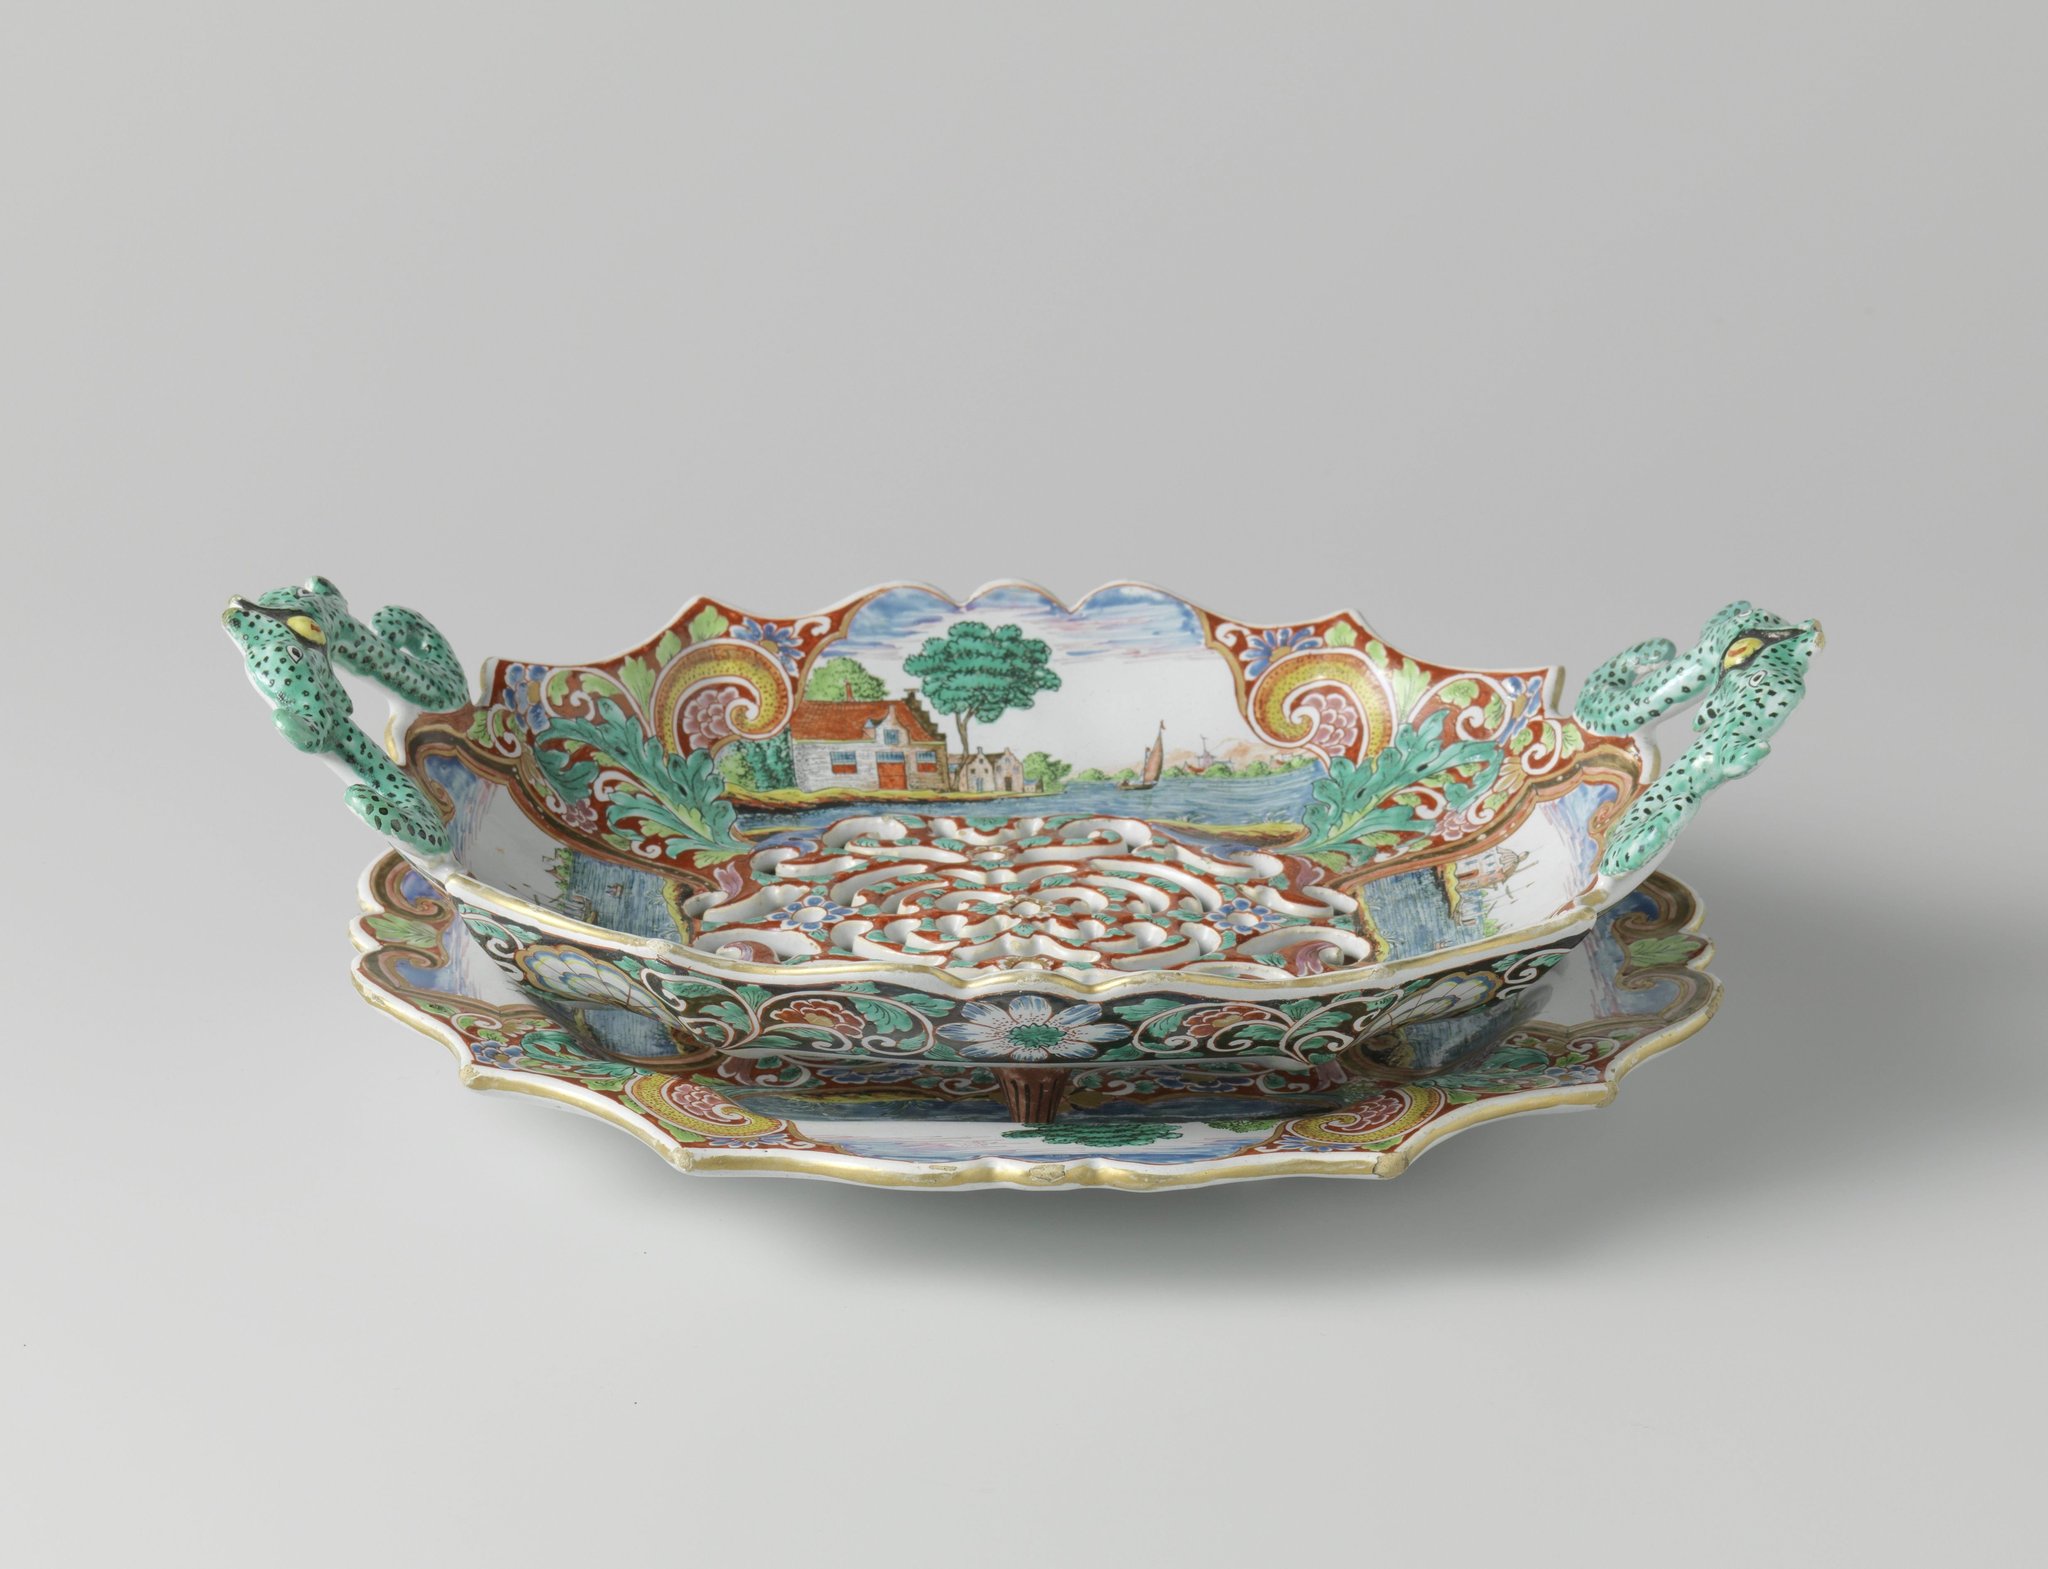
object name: platter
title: Fruittest, veelkleurig beschilderd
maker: Anonymous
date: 1760-1790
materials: faience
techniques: kiln, painted, polychromy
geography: delft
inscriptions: collector's mark: ‘collection J.F. Loudon’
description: Fruittest met geschulpte rand, opengewerkte bodem en twee oortjes in de vorm van dolfijnen.